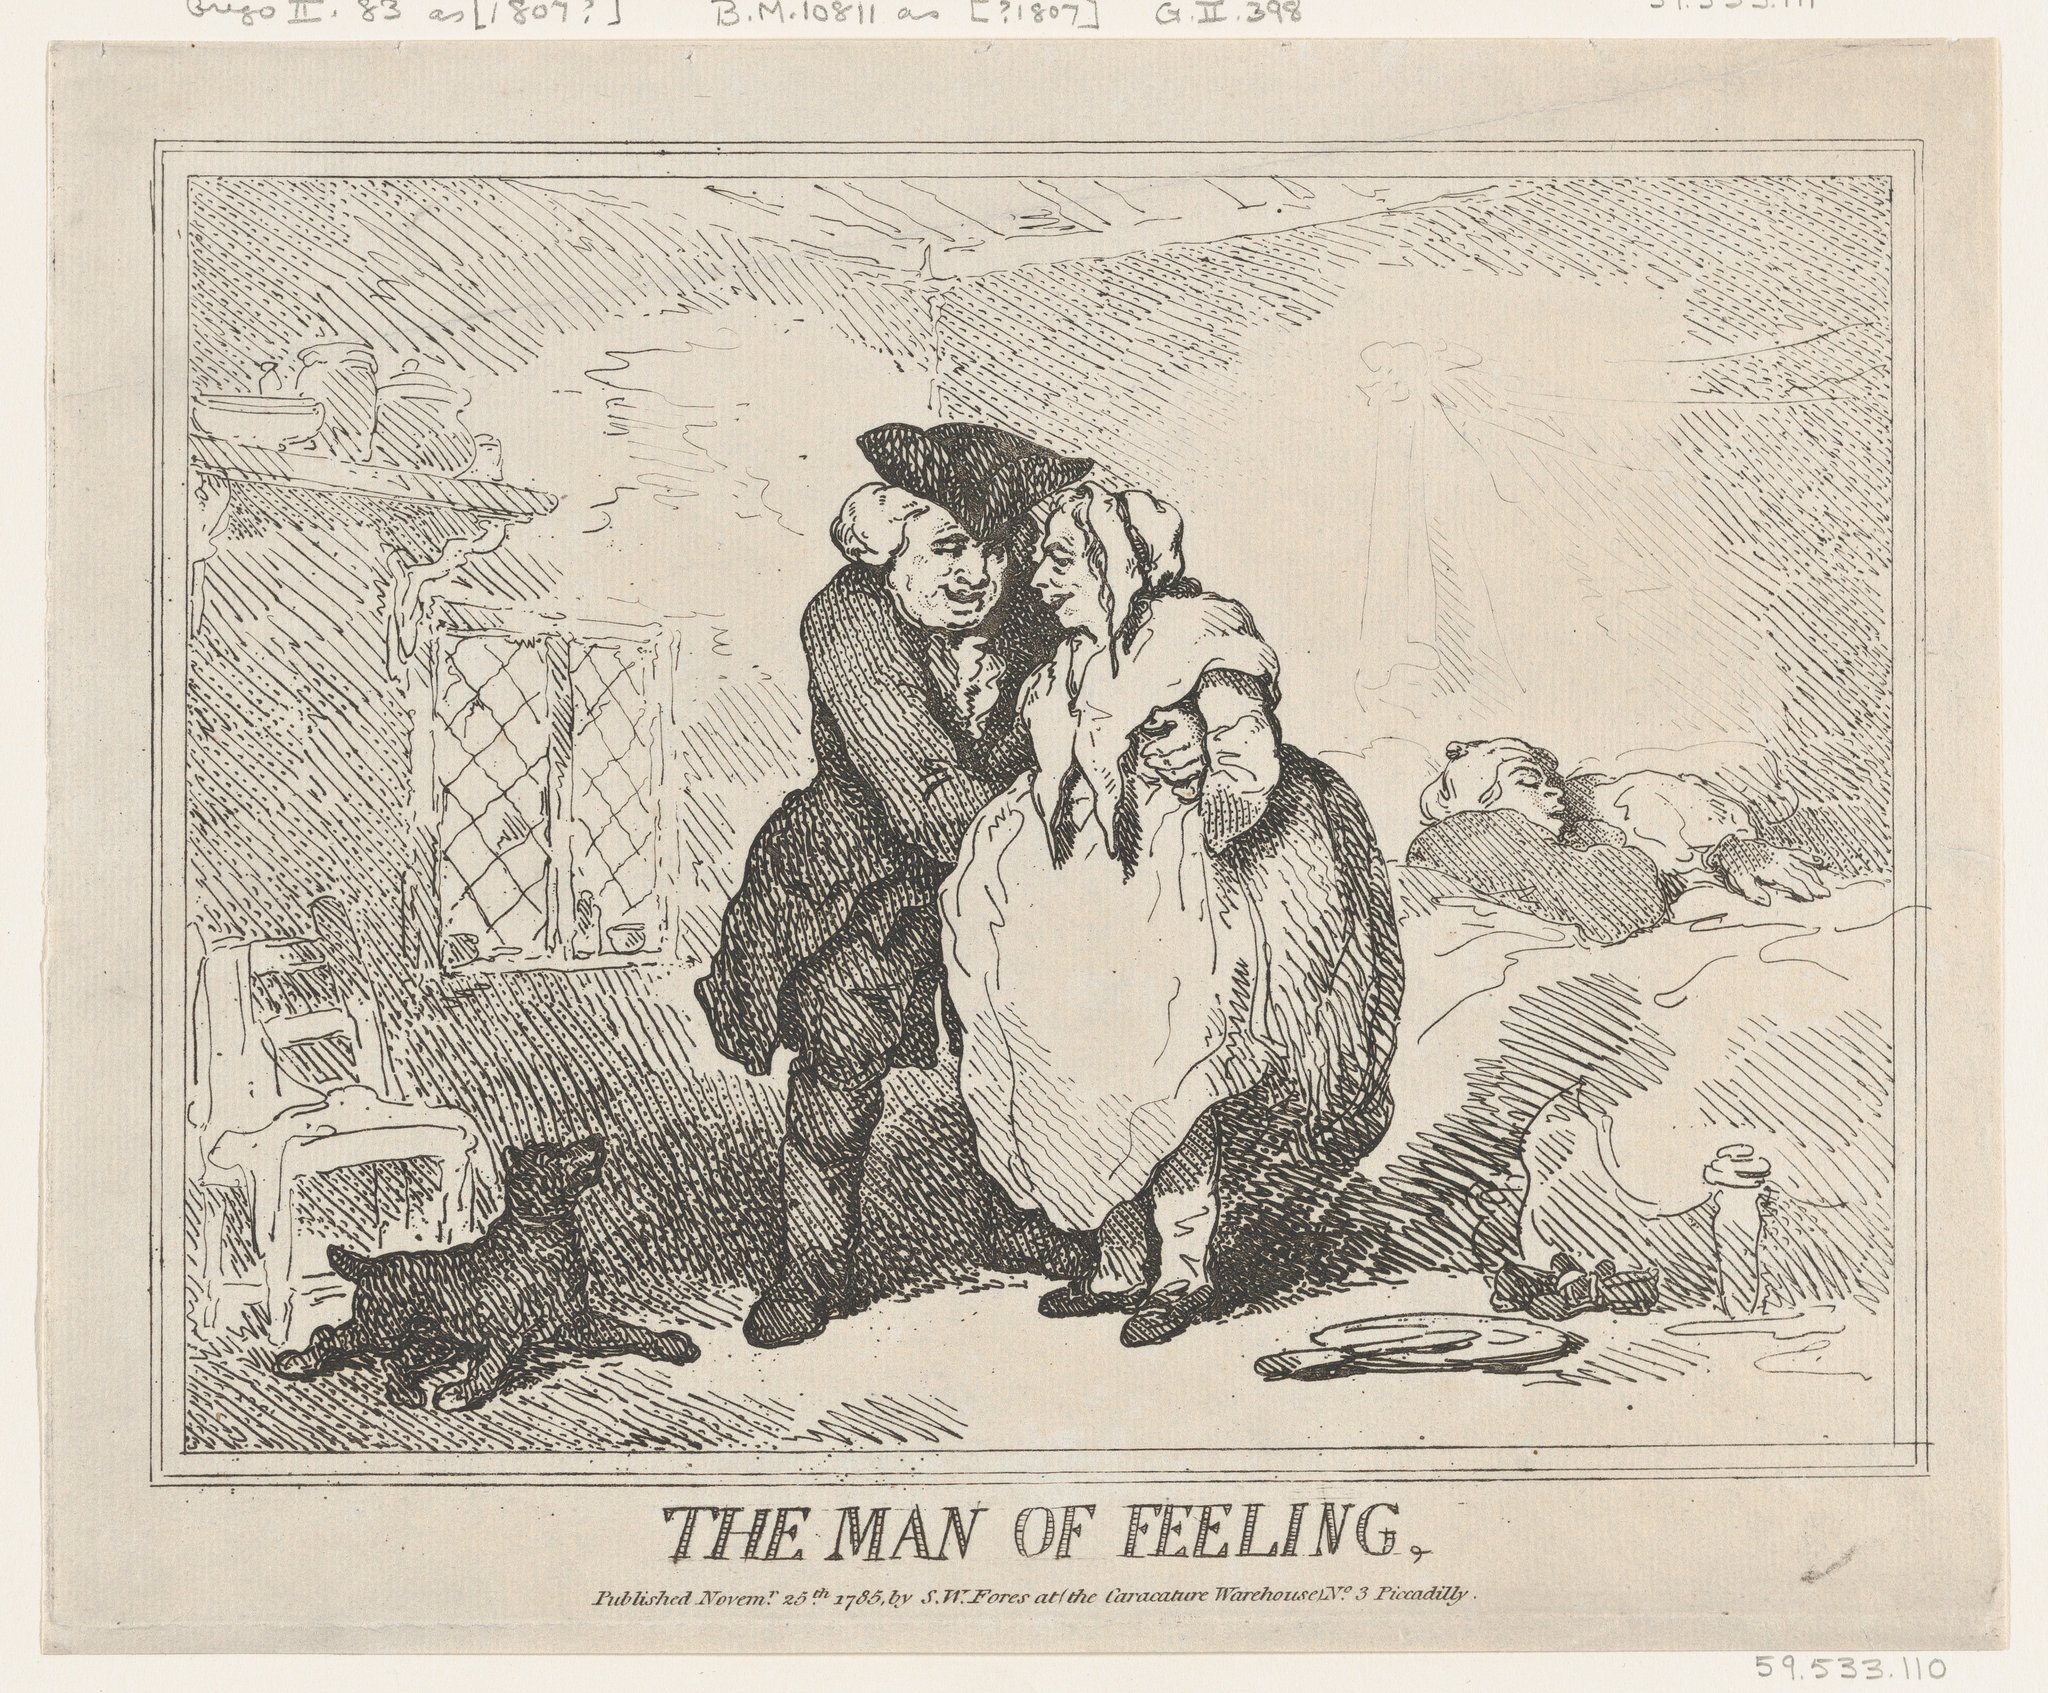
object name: print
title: The Man of Feeling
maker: thomas rowlandson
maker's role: artist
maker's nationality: british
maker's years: 1757-1827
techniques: etching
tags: men,women,dogs